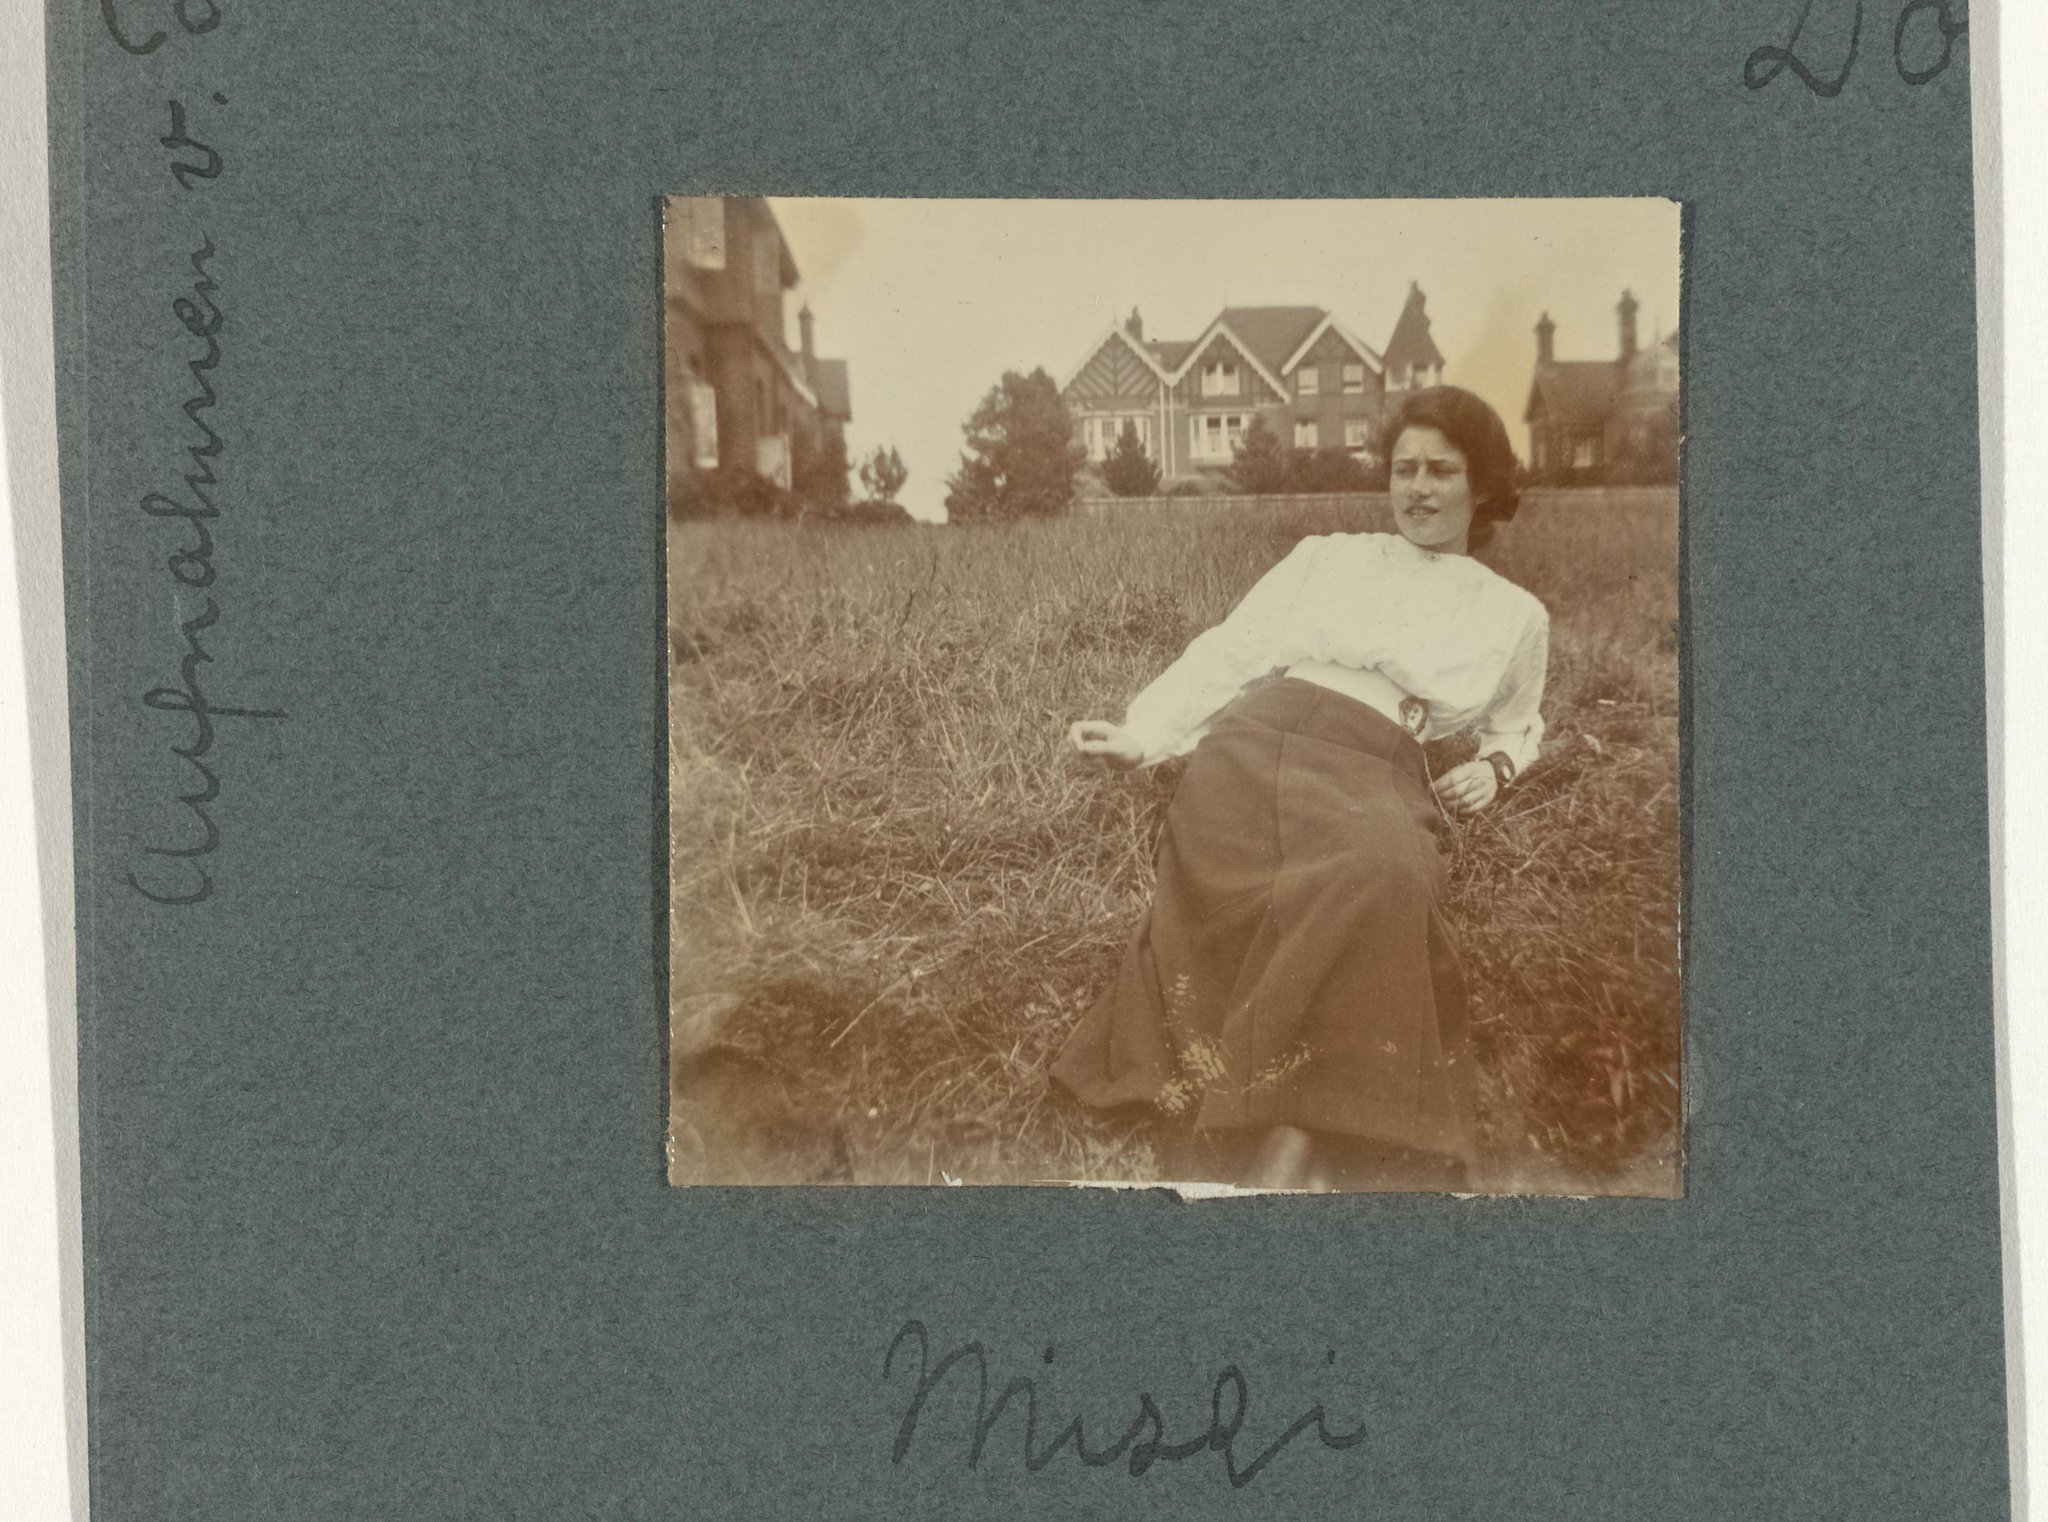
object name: photograph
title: Misli in landelijke omgeving met gebouw op de achtergrond in Bexhill-on-Sea in Engeland, 1913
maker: Anonymous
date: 1913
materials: photographic support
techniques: gelatin silver print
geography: bexhill-on-sea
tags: england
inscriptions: inscription: ‘Misli’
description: Misli in landelijke omgeving met gebouw op de achtergrond in Bexhill-on-Sea in Engeland.